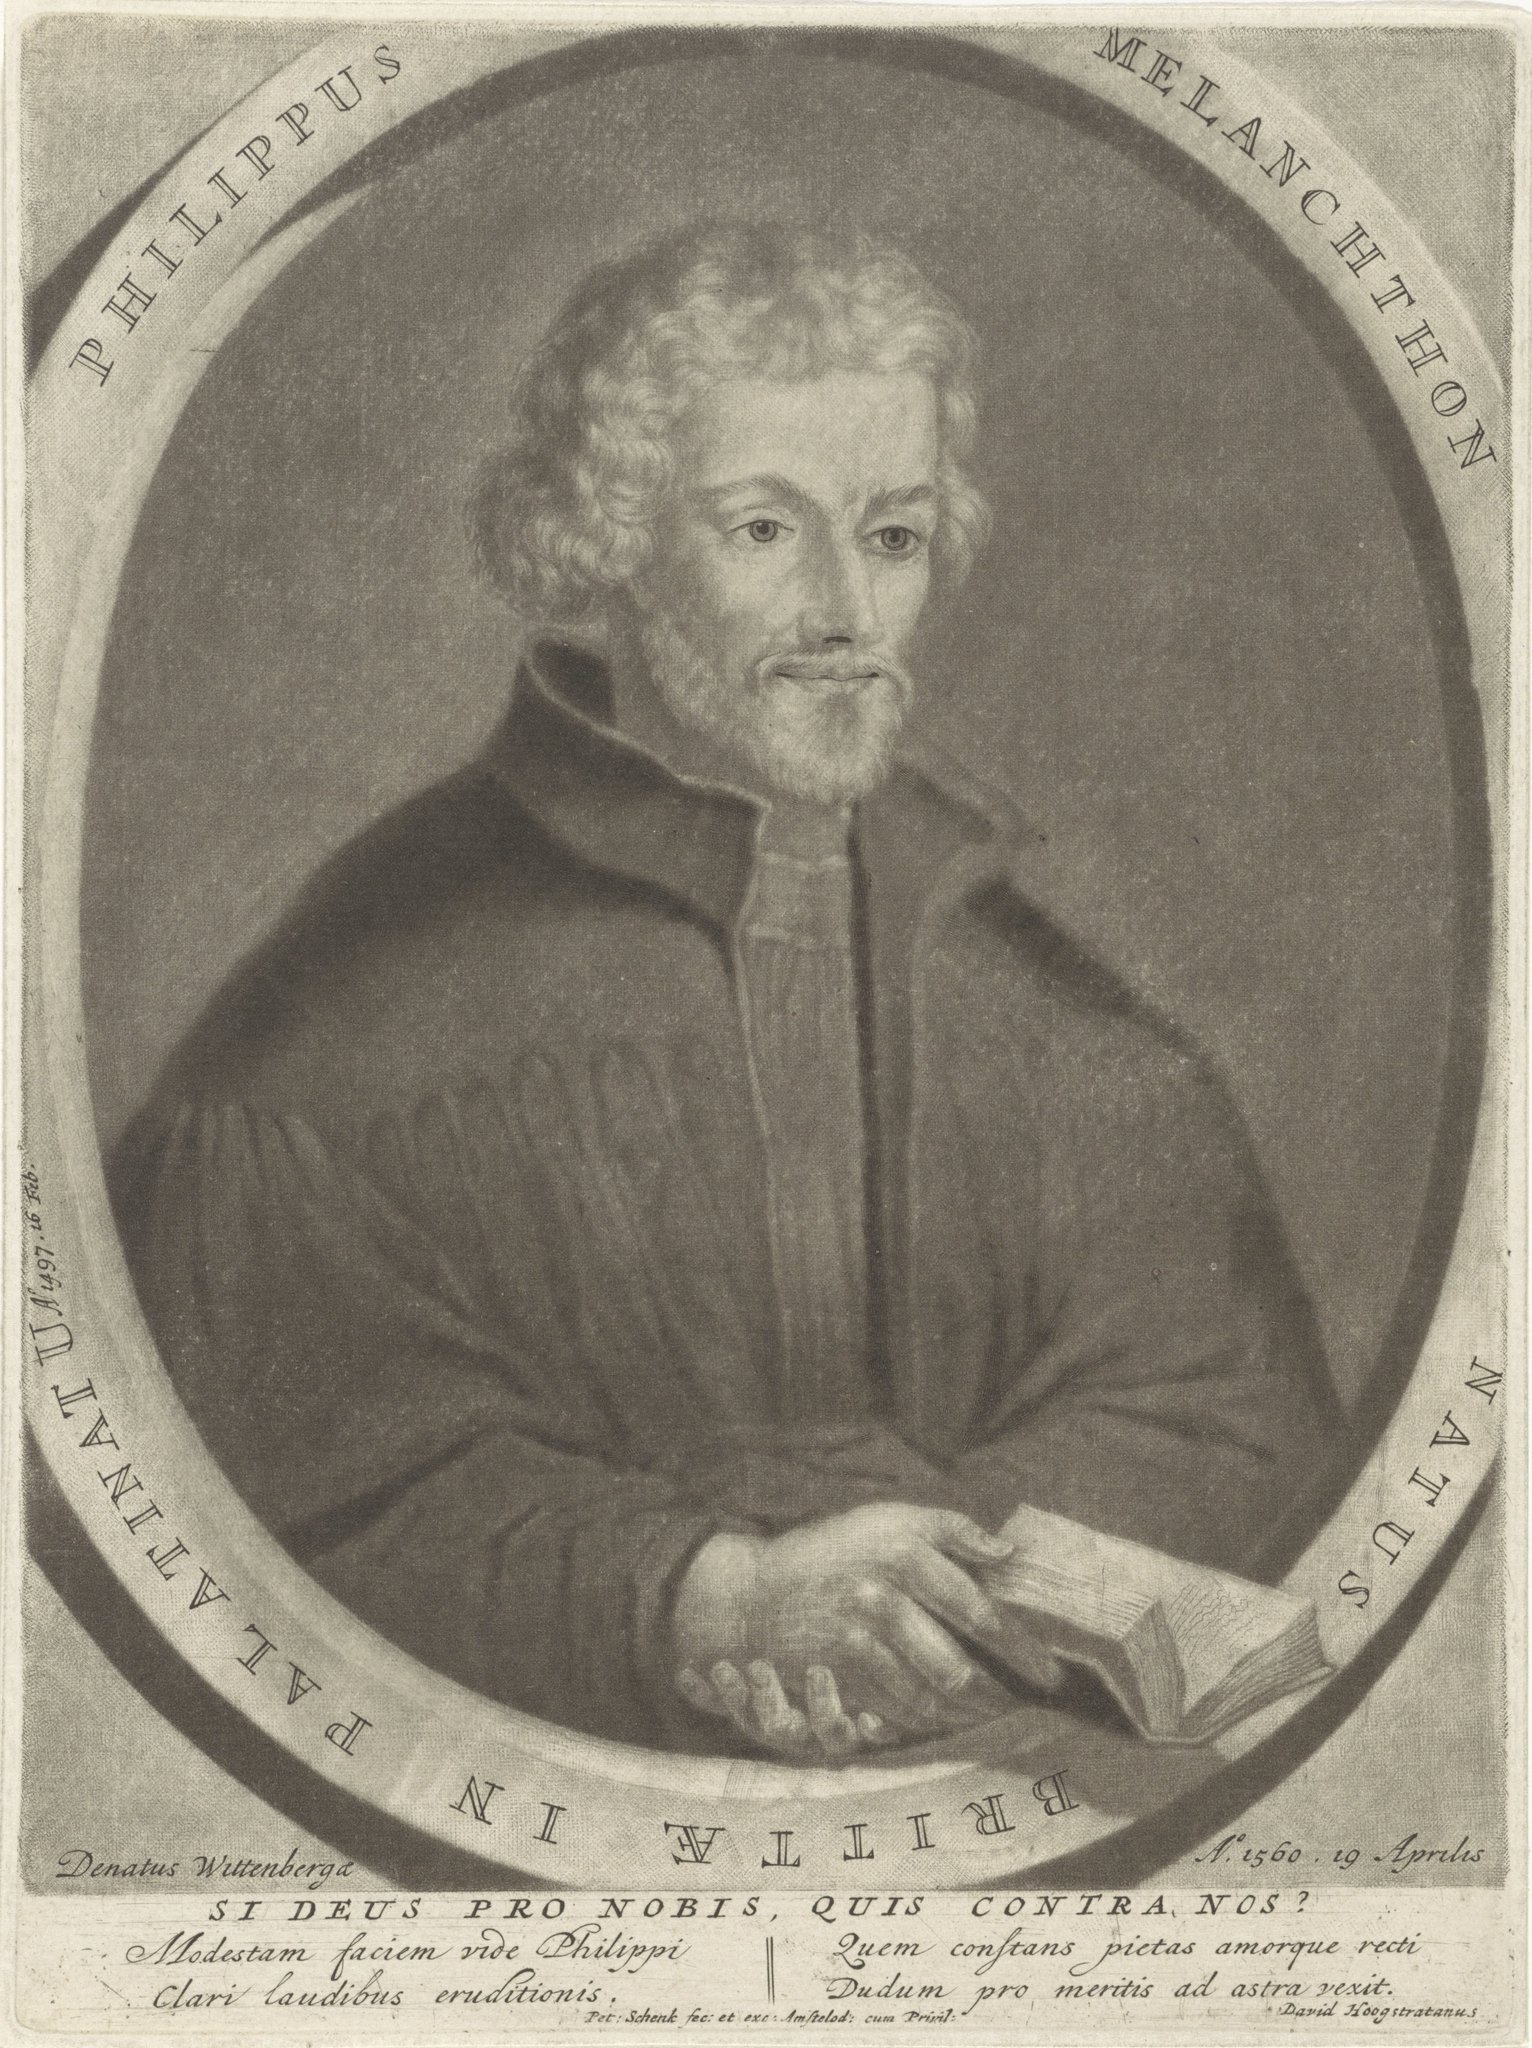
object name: print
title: Portret van Philipp Melanchthon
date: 1670-1713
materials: paper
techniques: engraving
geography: amsterdam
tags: book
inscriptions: collector's mark: Lugt 2228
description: De Duitse humanist Philipp Melanchthon met in zijn hand een boek.